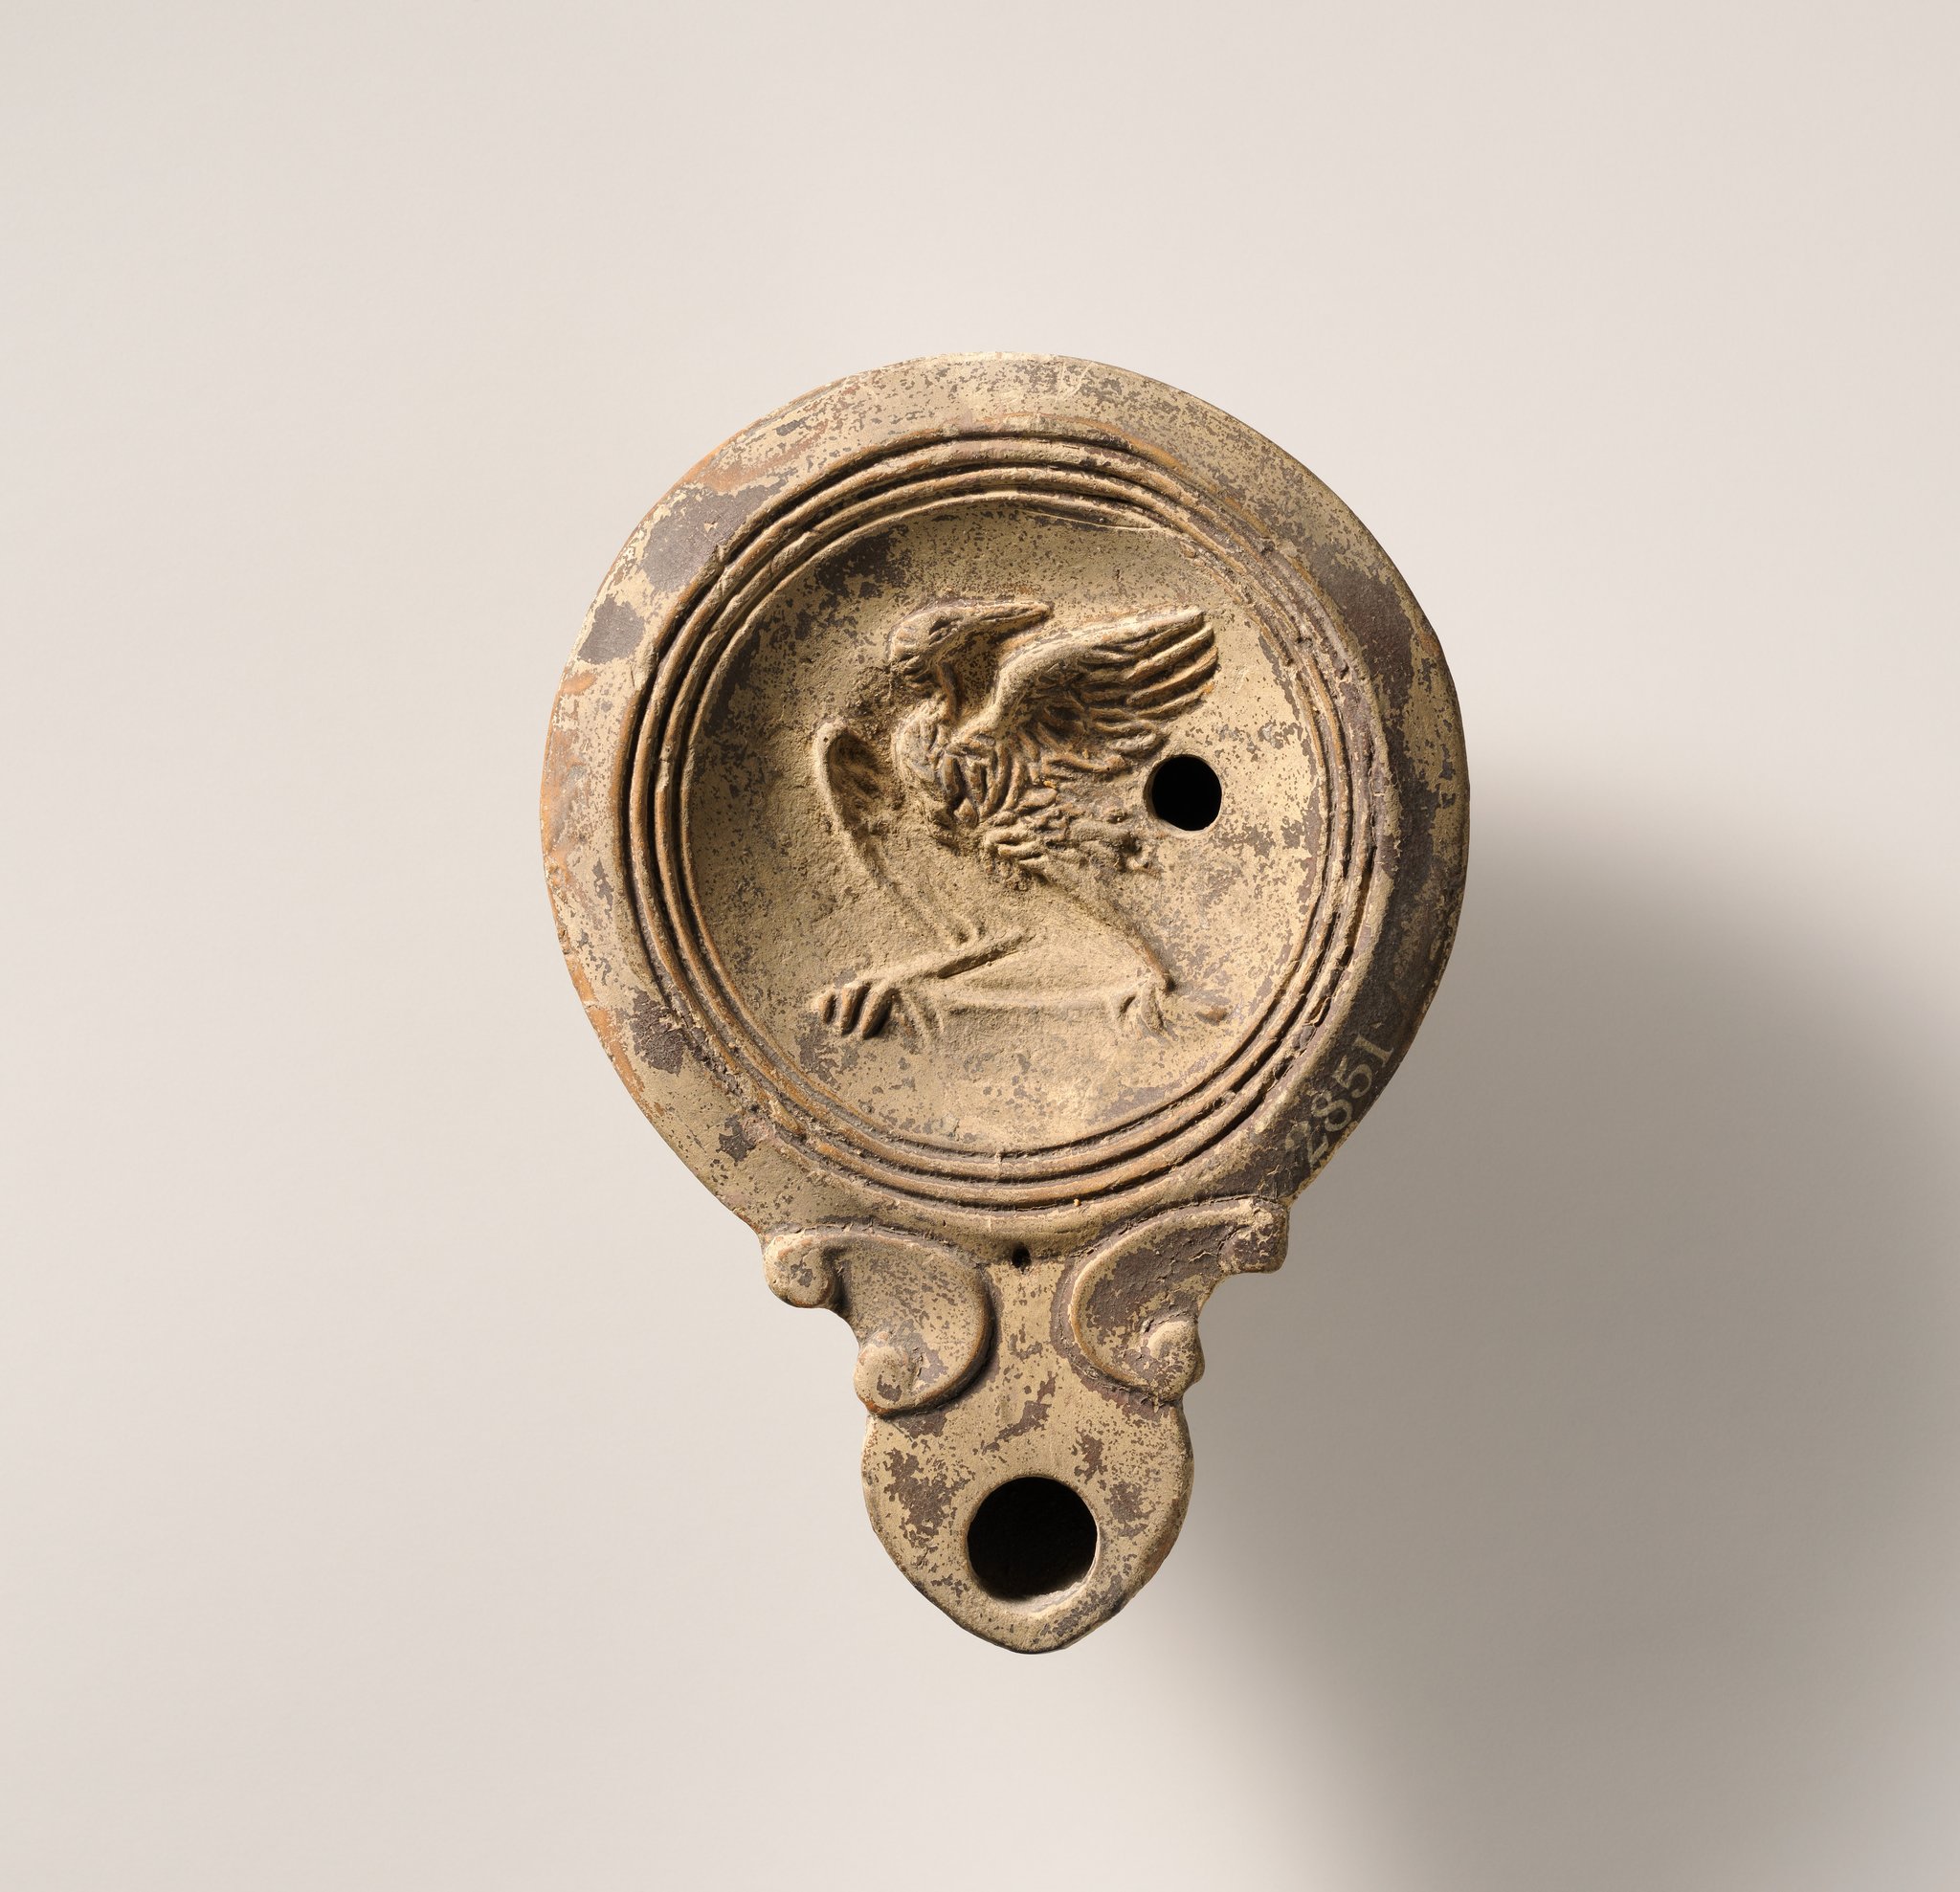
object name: lamp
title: Terracotta oil lamp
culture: roman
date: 1-100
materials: terracotta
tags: birds